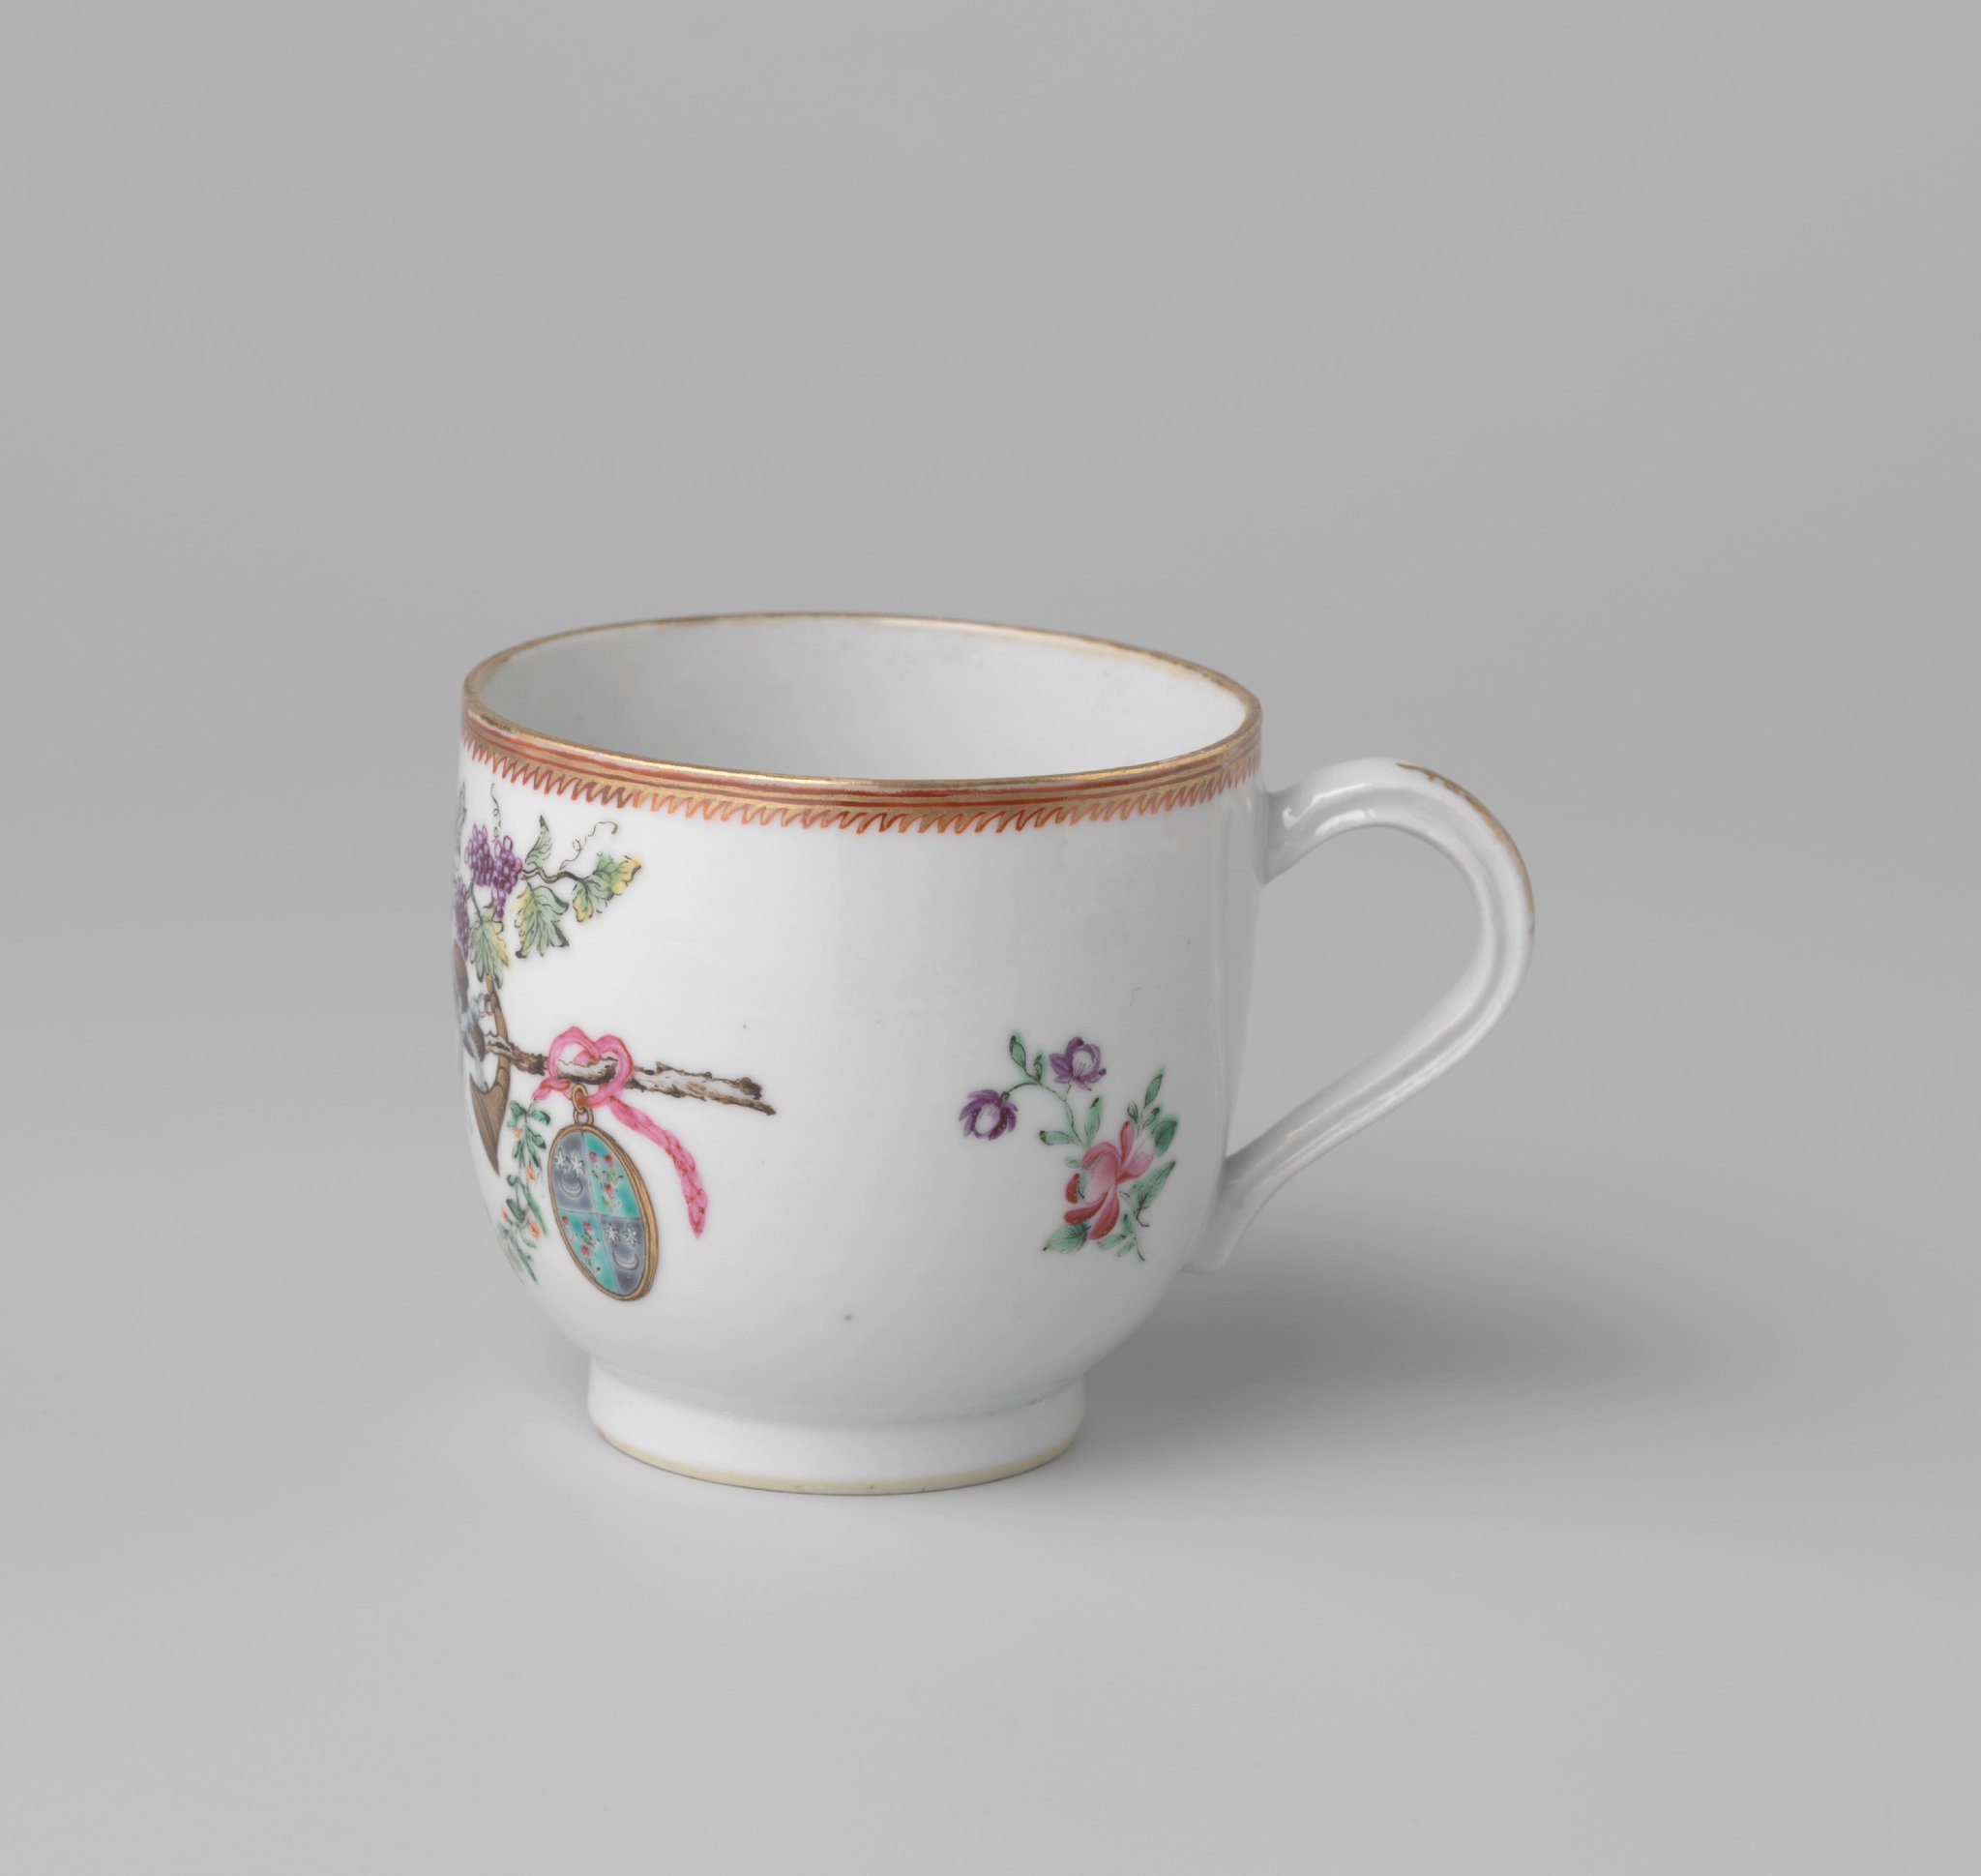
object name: cup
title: Cup with handle with the arms of the Visvliet and Sluymer families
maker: Anonymous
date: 1777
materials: glaze, gold, paint, porcelain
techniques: firing, gilding, turning, vitrification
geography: china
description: Kop en schotel van porselein. Versierd met bloem- en vruchtentakken en een stok waaraan een hoed, een blad papier een hoorn en 2 wapenschilden zijn bevestigd. De wapens zijn van de families Visvliet en Sluymer (uit Zeeland).